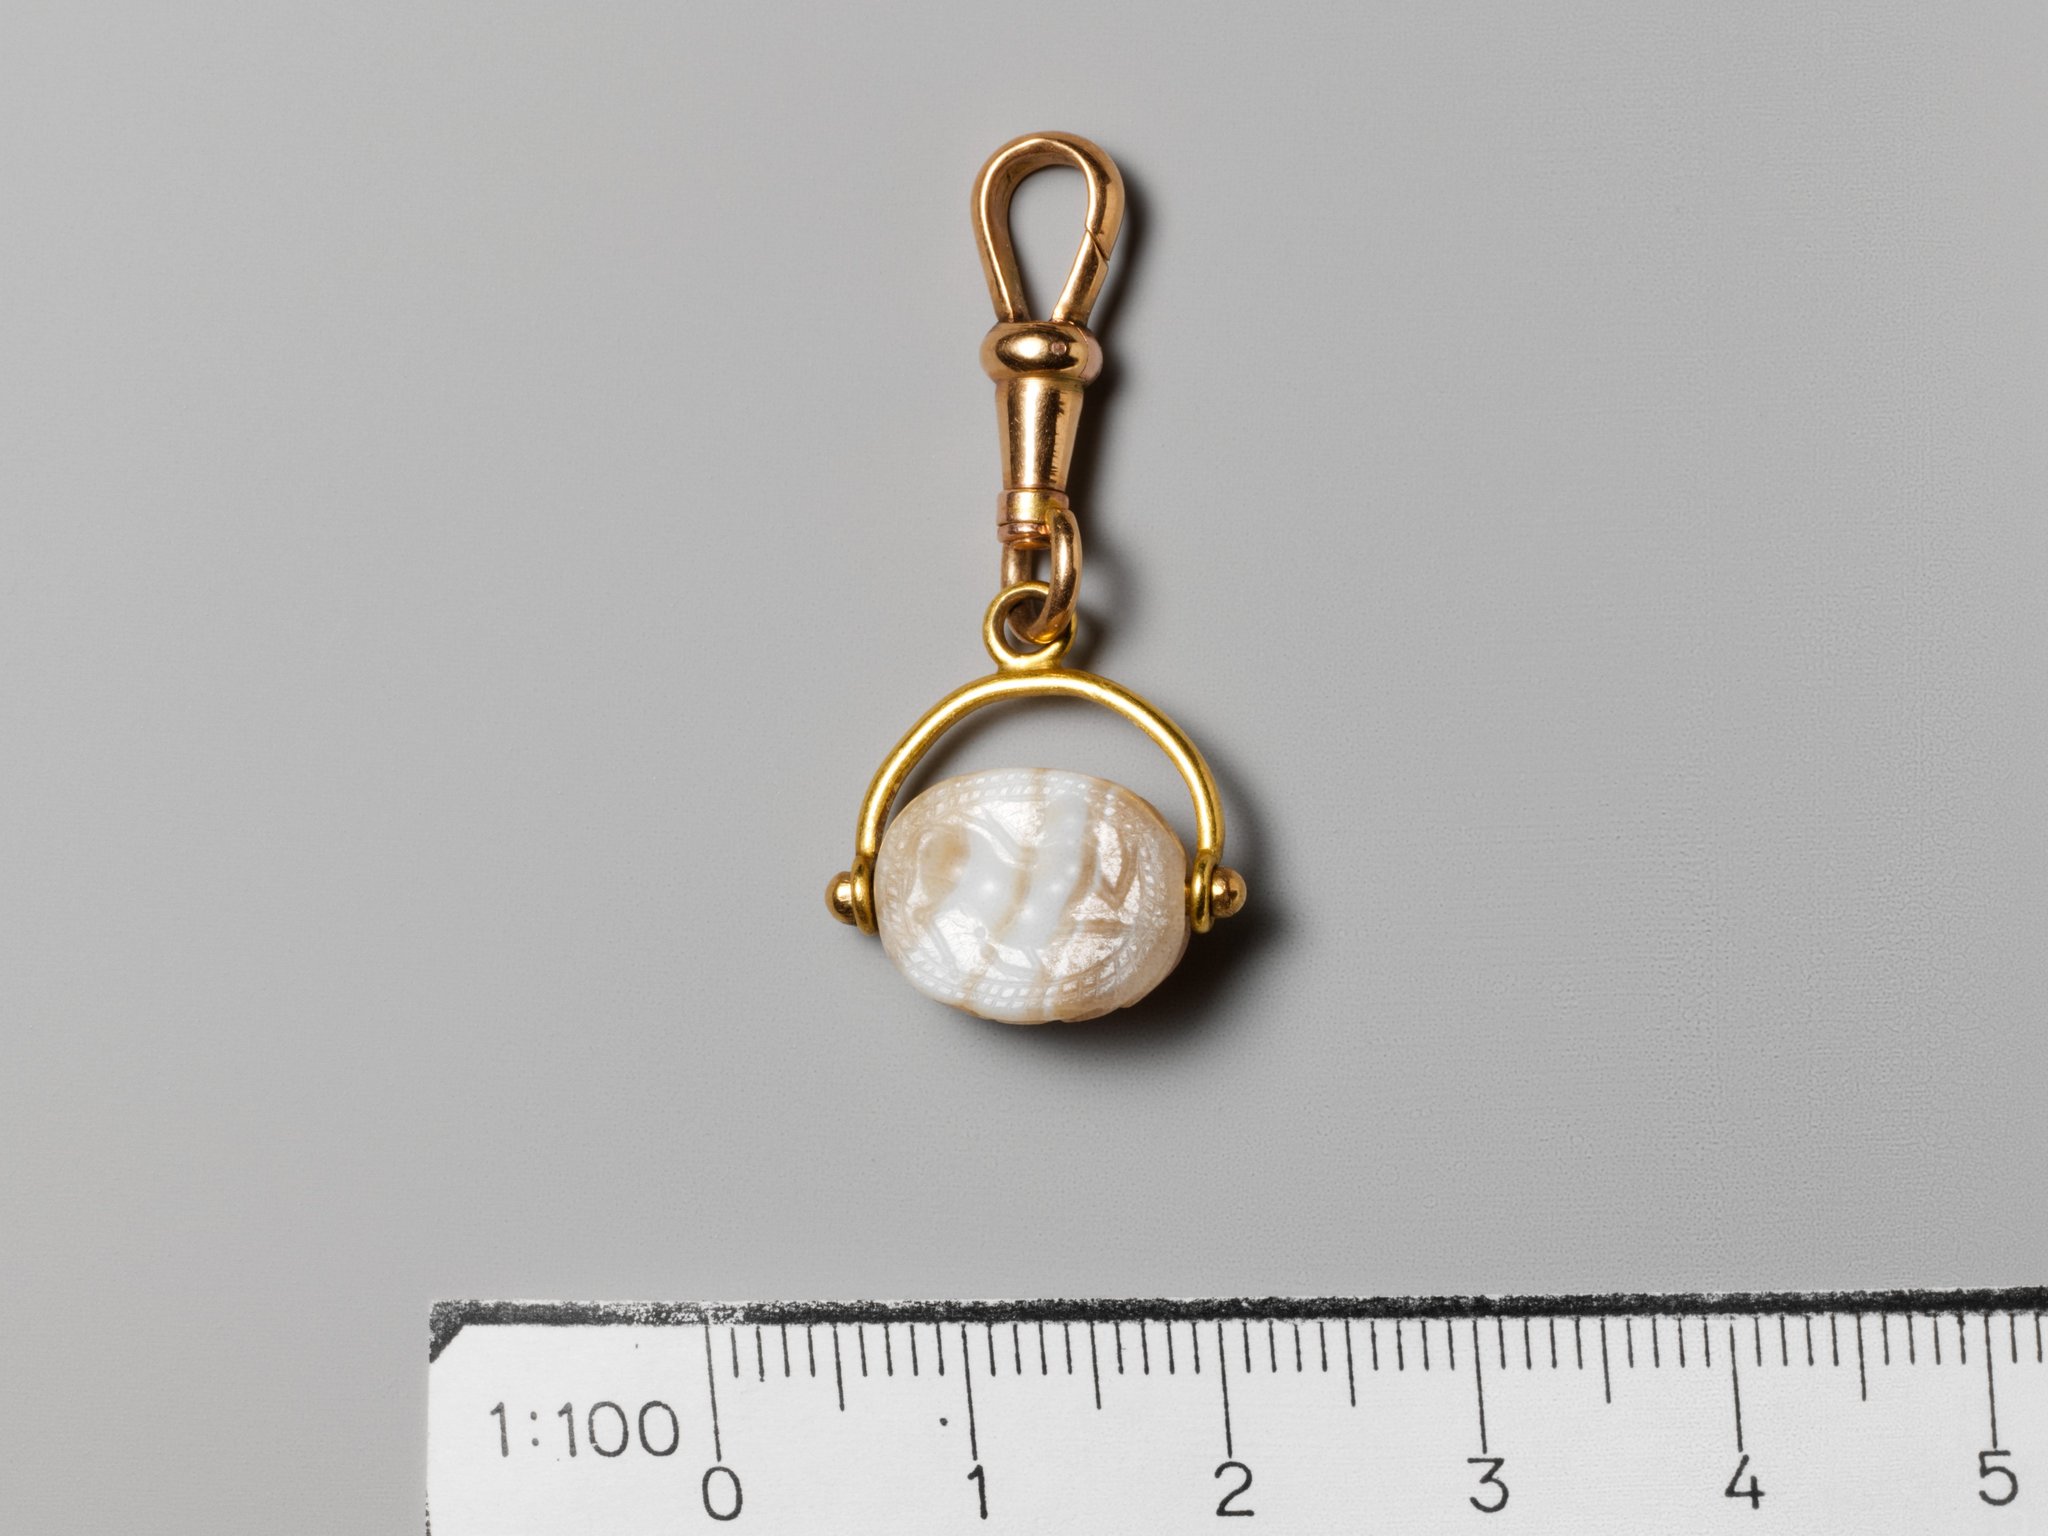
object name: ring with scarab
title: Banded agate scarab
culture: etruscan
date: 300-201 BCE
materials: stone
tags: centaurs,scarabs